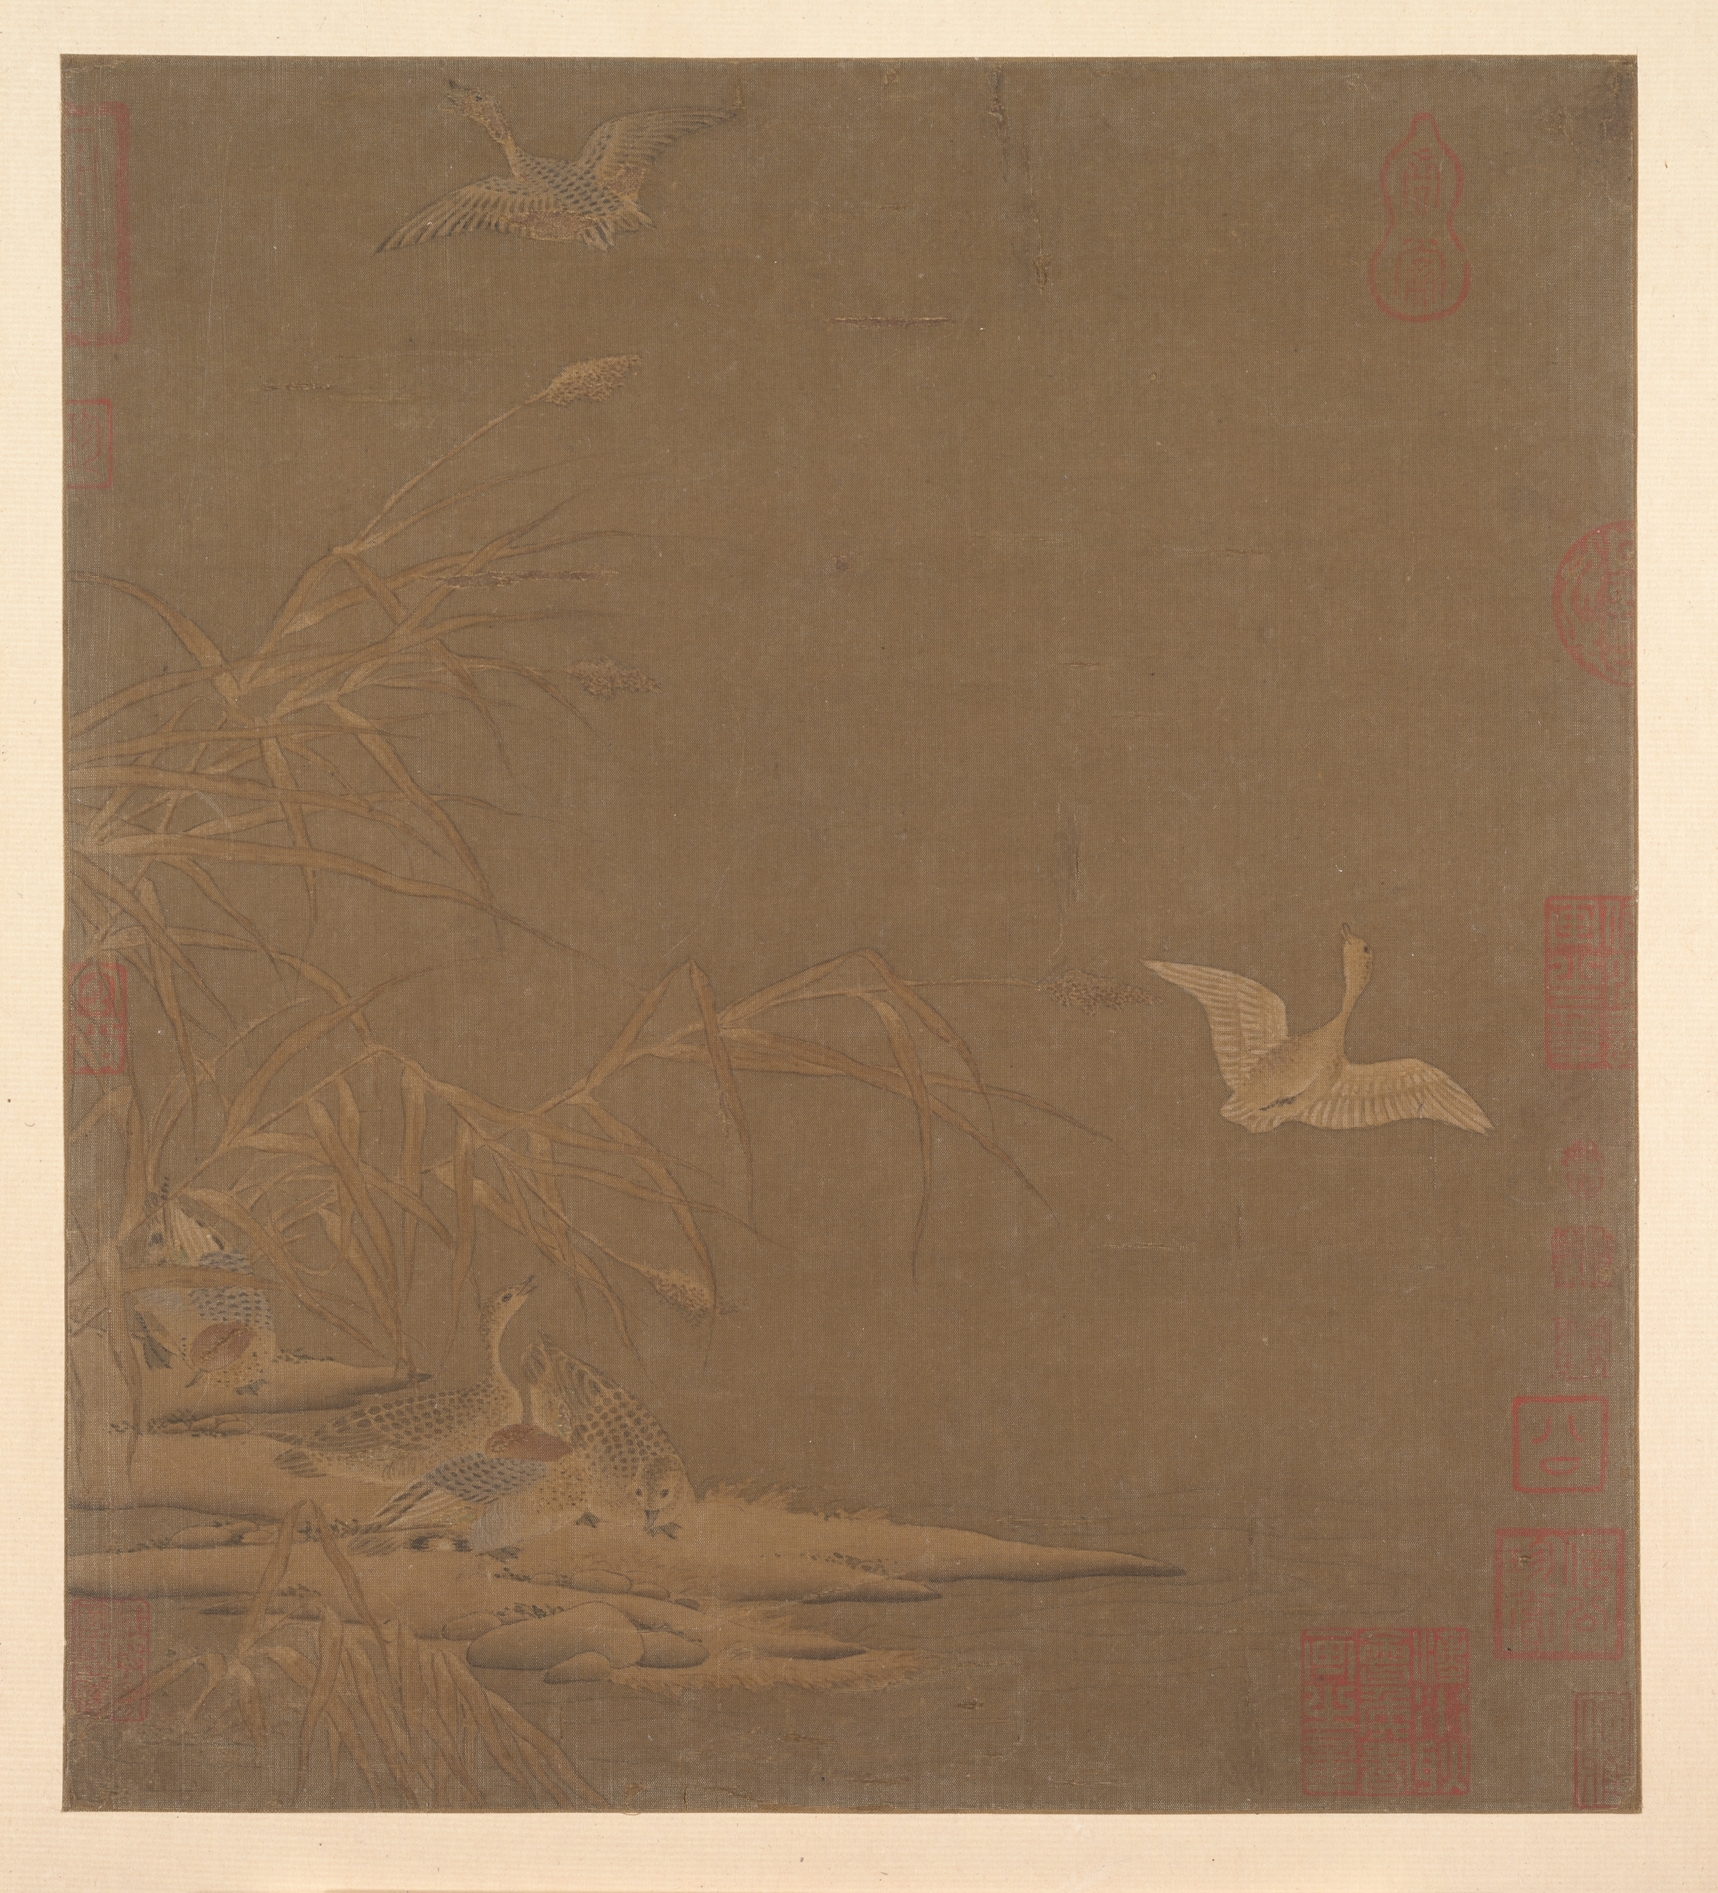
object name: album leaf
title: Wild Geese in Winter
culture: chinese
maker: unidentified artist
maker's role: artist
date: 1201-1300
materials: ink, silk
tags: geese